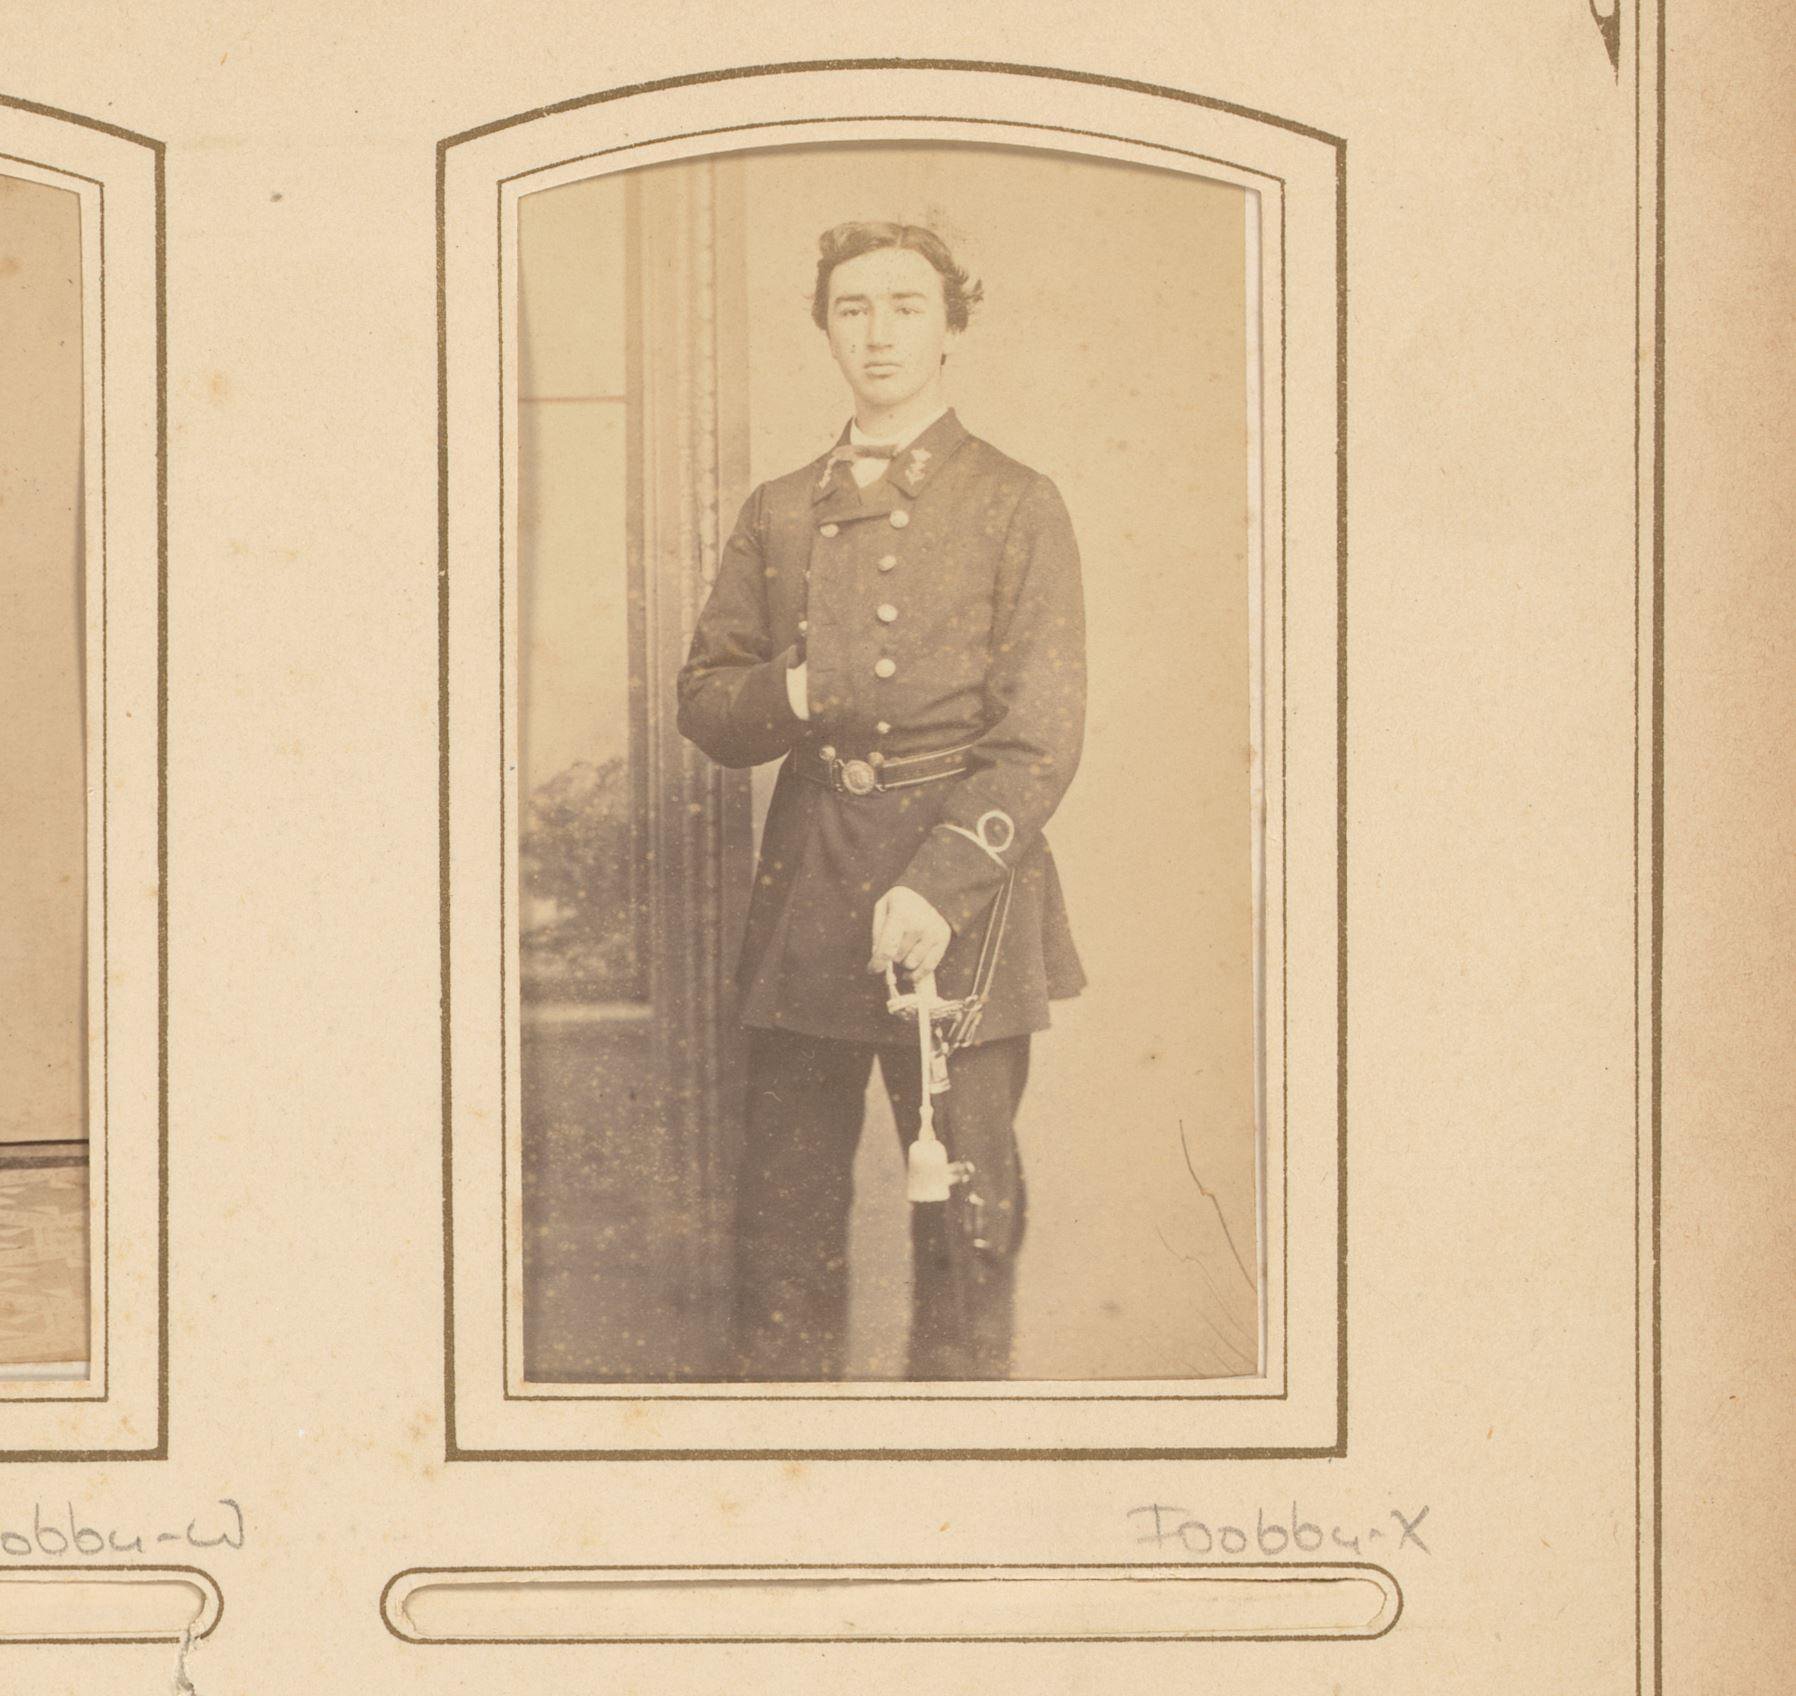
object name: album leaf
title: Portret van H. Kloek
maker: c. j. korsten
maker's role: painter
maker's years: 1829-1914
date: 1868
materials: cardboard, photographic support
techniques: albumen print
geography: hellevoetsluis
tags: historical persons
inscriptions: inscription: ‘Photographish Atelier van/ C.J. Korsten/ Zierikzee’, annotation: ‘Hellevoetsluis 26 dec 68/ a/b Z.M.Wachtschip de [Chijn]/ H. Kloek’